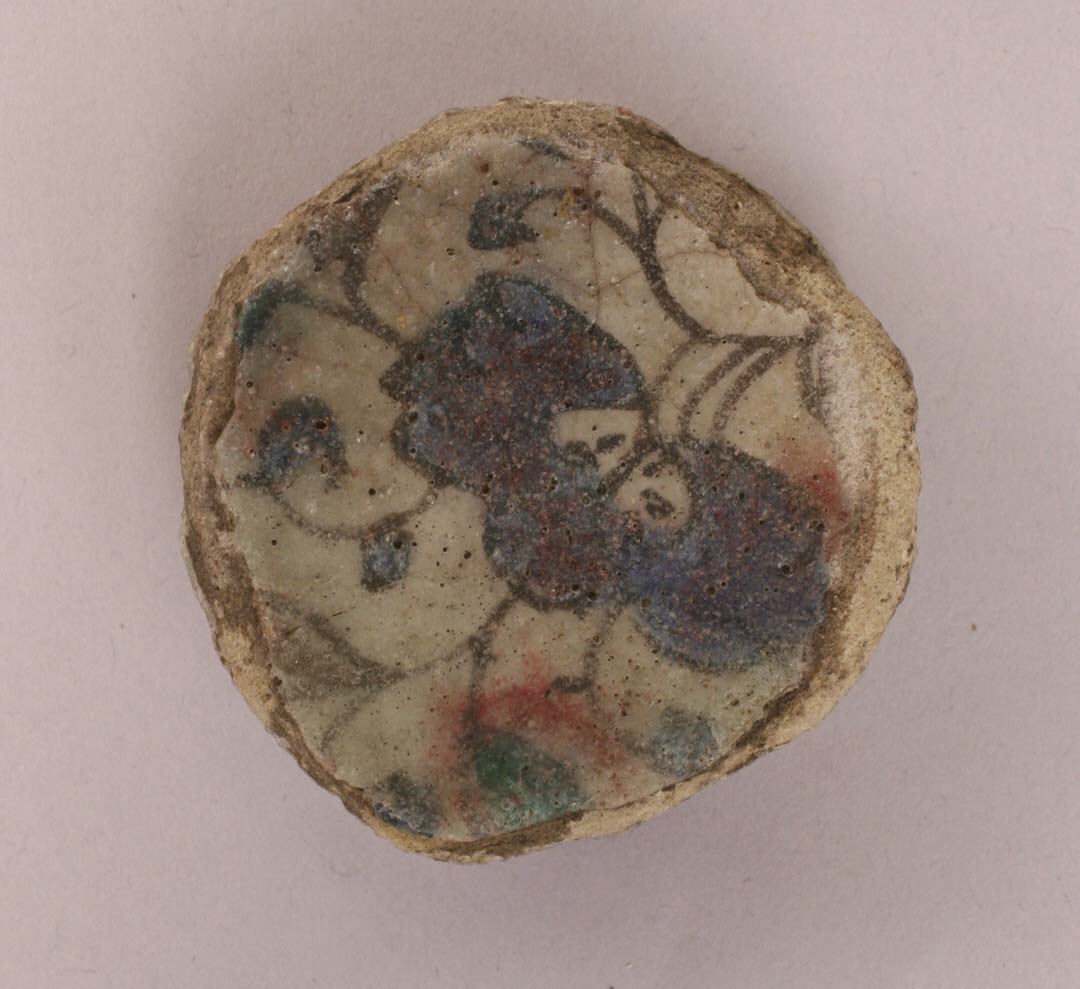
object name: fragment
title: Ceramic Fragment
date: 1201-1600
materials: glaze, stonepaste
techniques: painting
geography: egypt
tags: flowers